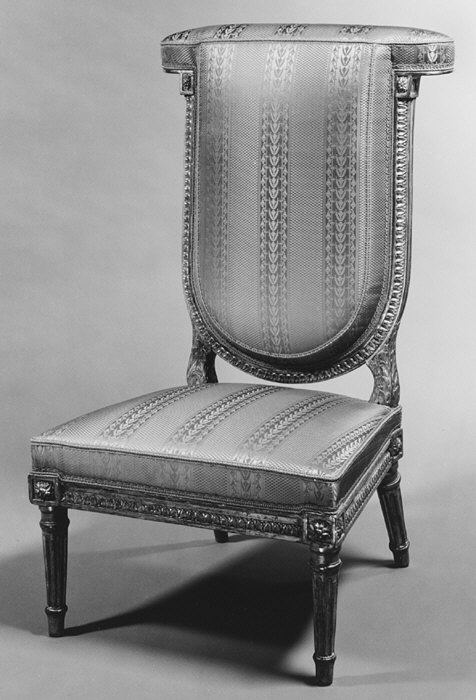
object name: side chair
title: Side chair (voyeuse à genoux)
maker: louis magdeleine pluvinet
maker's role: maker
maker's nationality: french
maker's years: 1745-1815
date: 1785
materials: silk, wood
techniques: carving, gilding